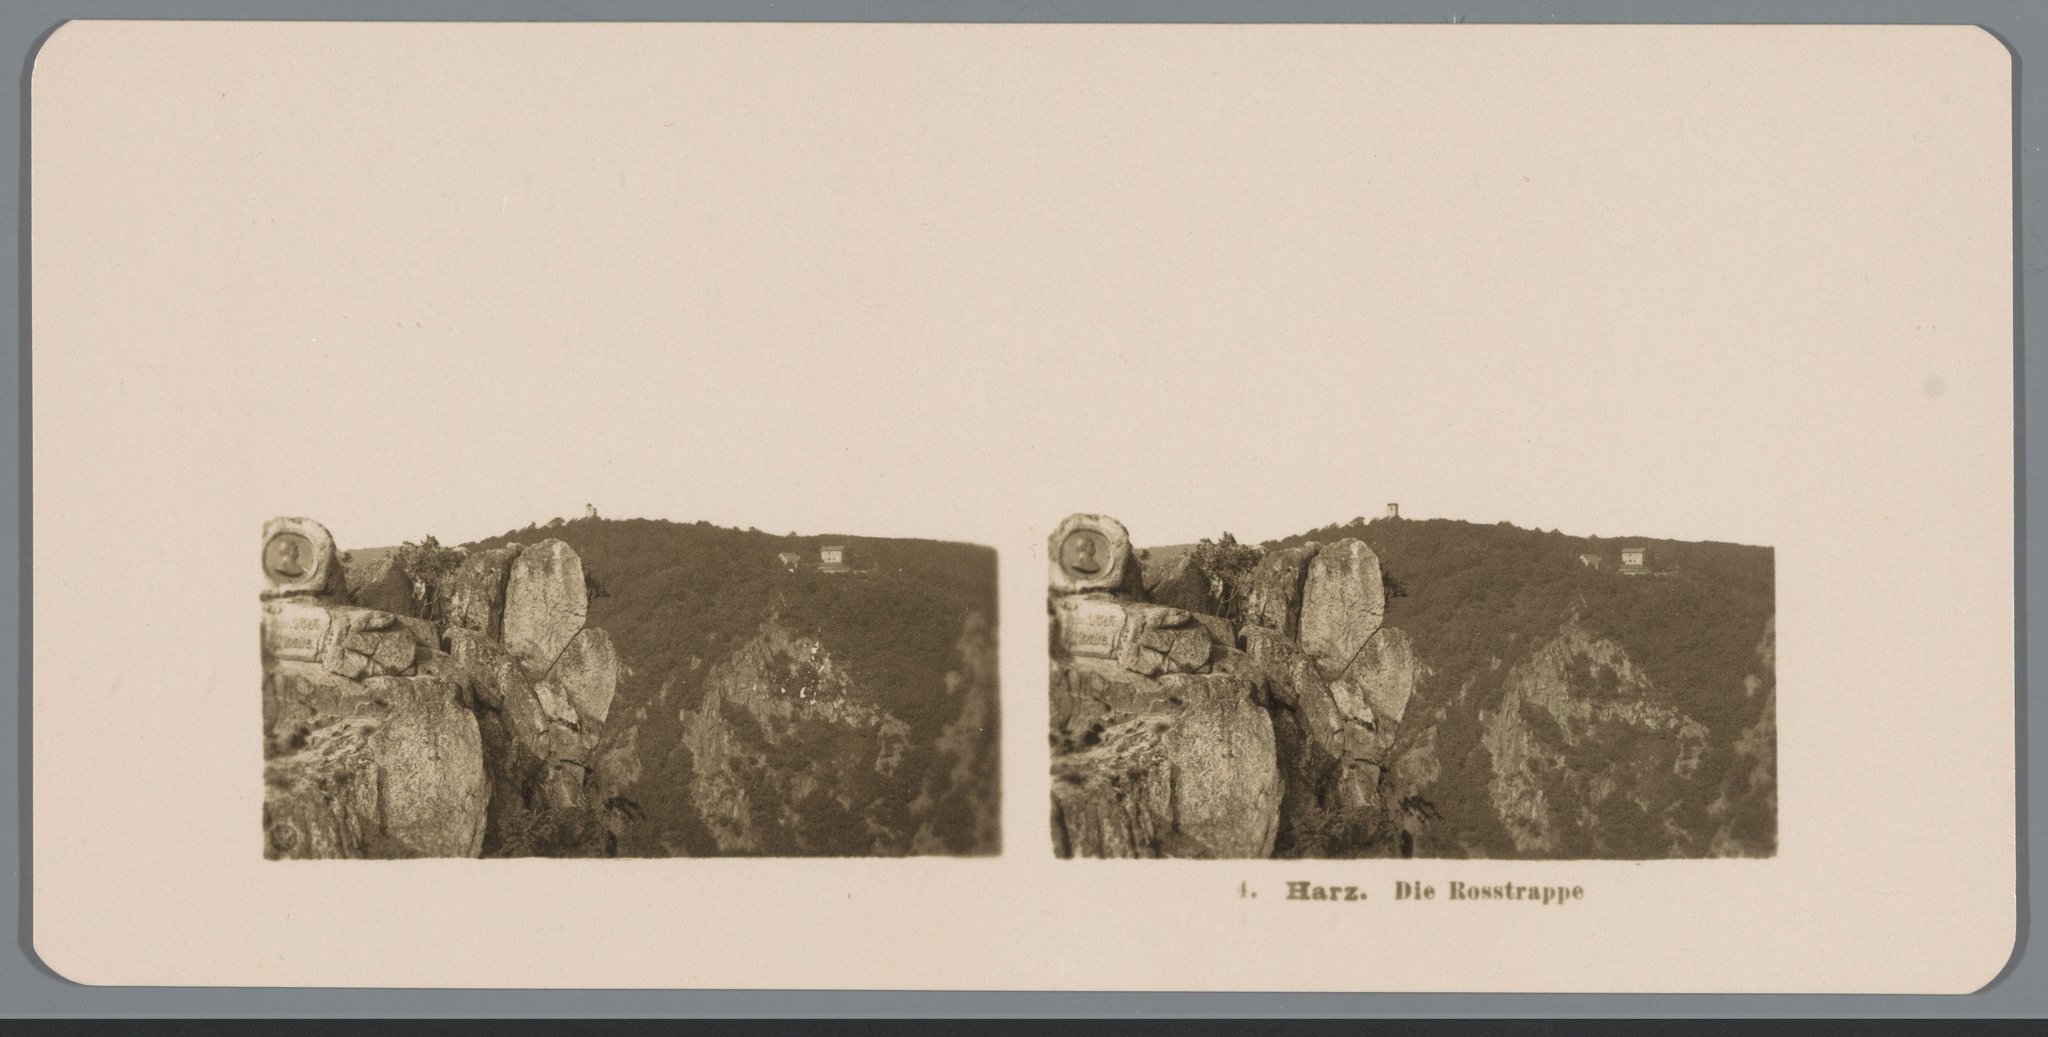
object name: stereograph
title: Harz. Die Rosstrappe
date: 1900-1910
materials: cardboard, photographic support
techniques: gelatin silver print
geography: harz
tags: mountain-top, peak, mountains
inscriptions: inscription: ‘NPG’, number: ‘1.’